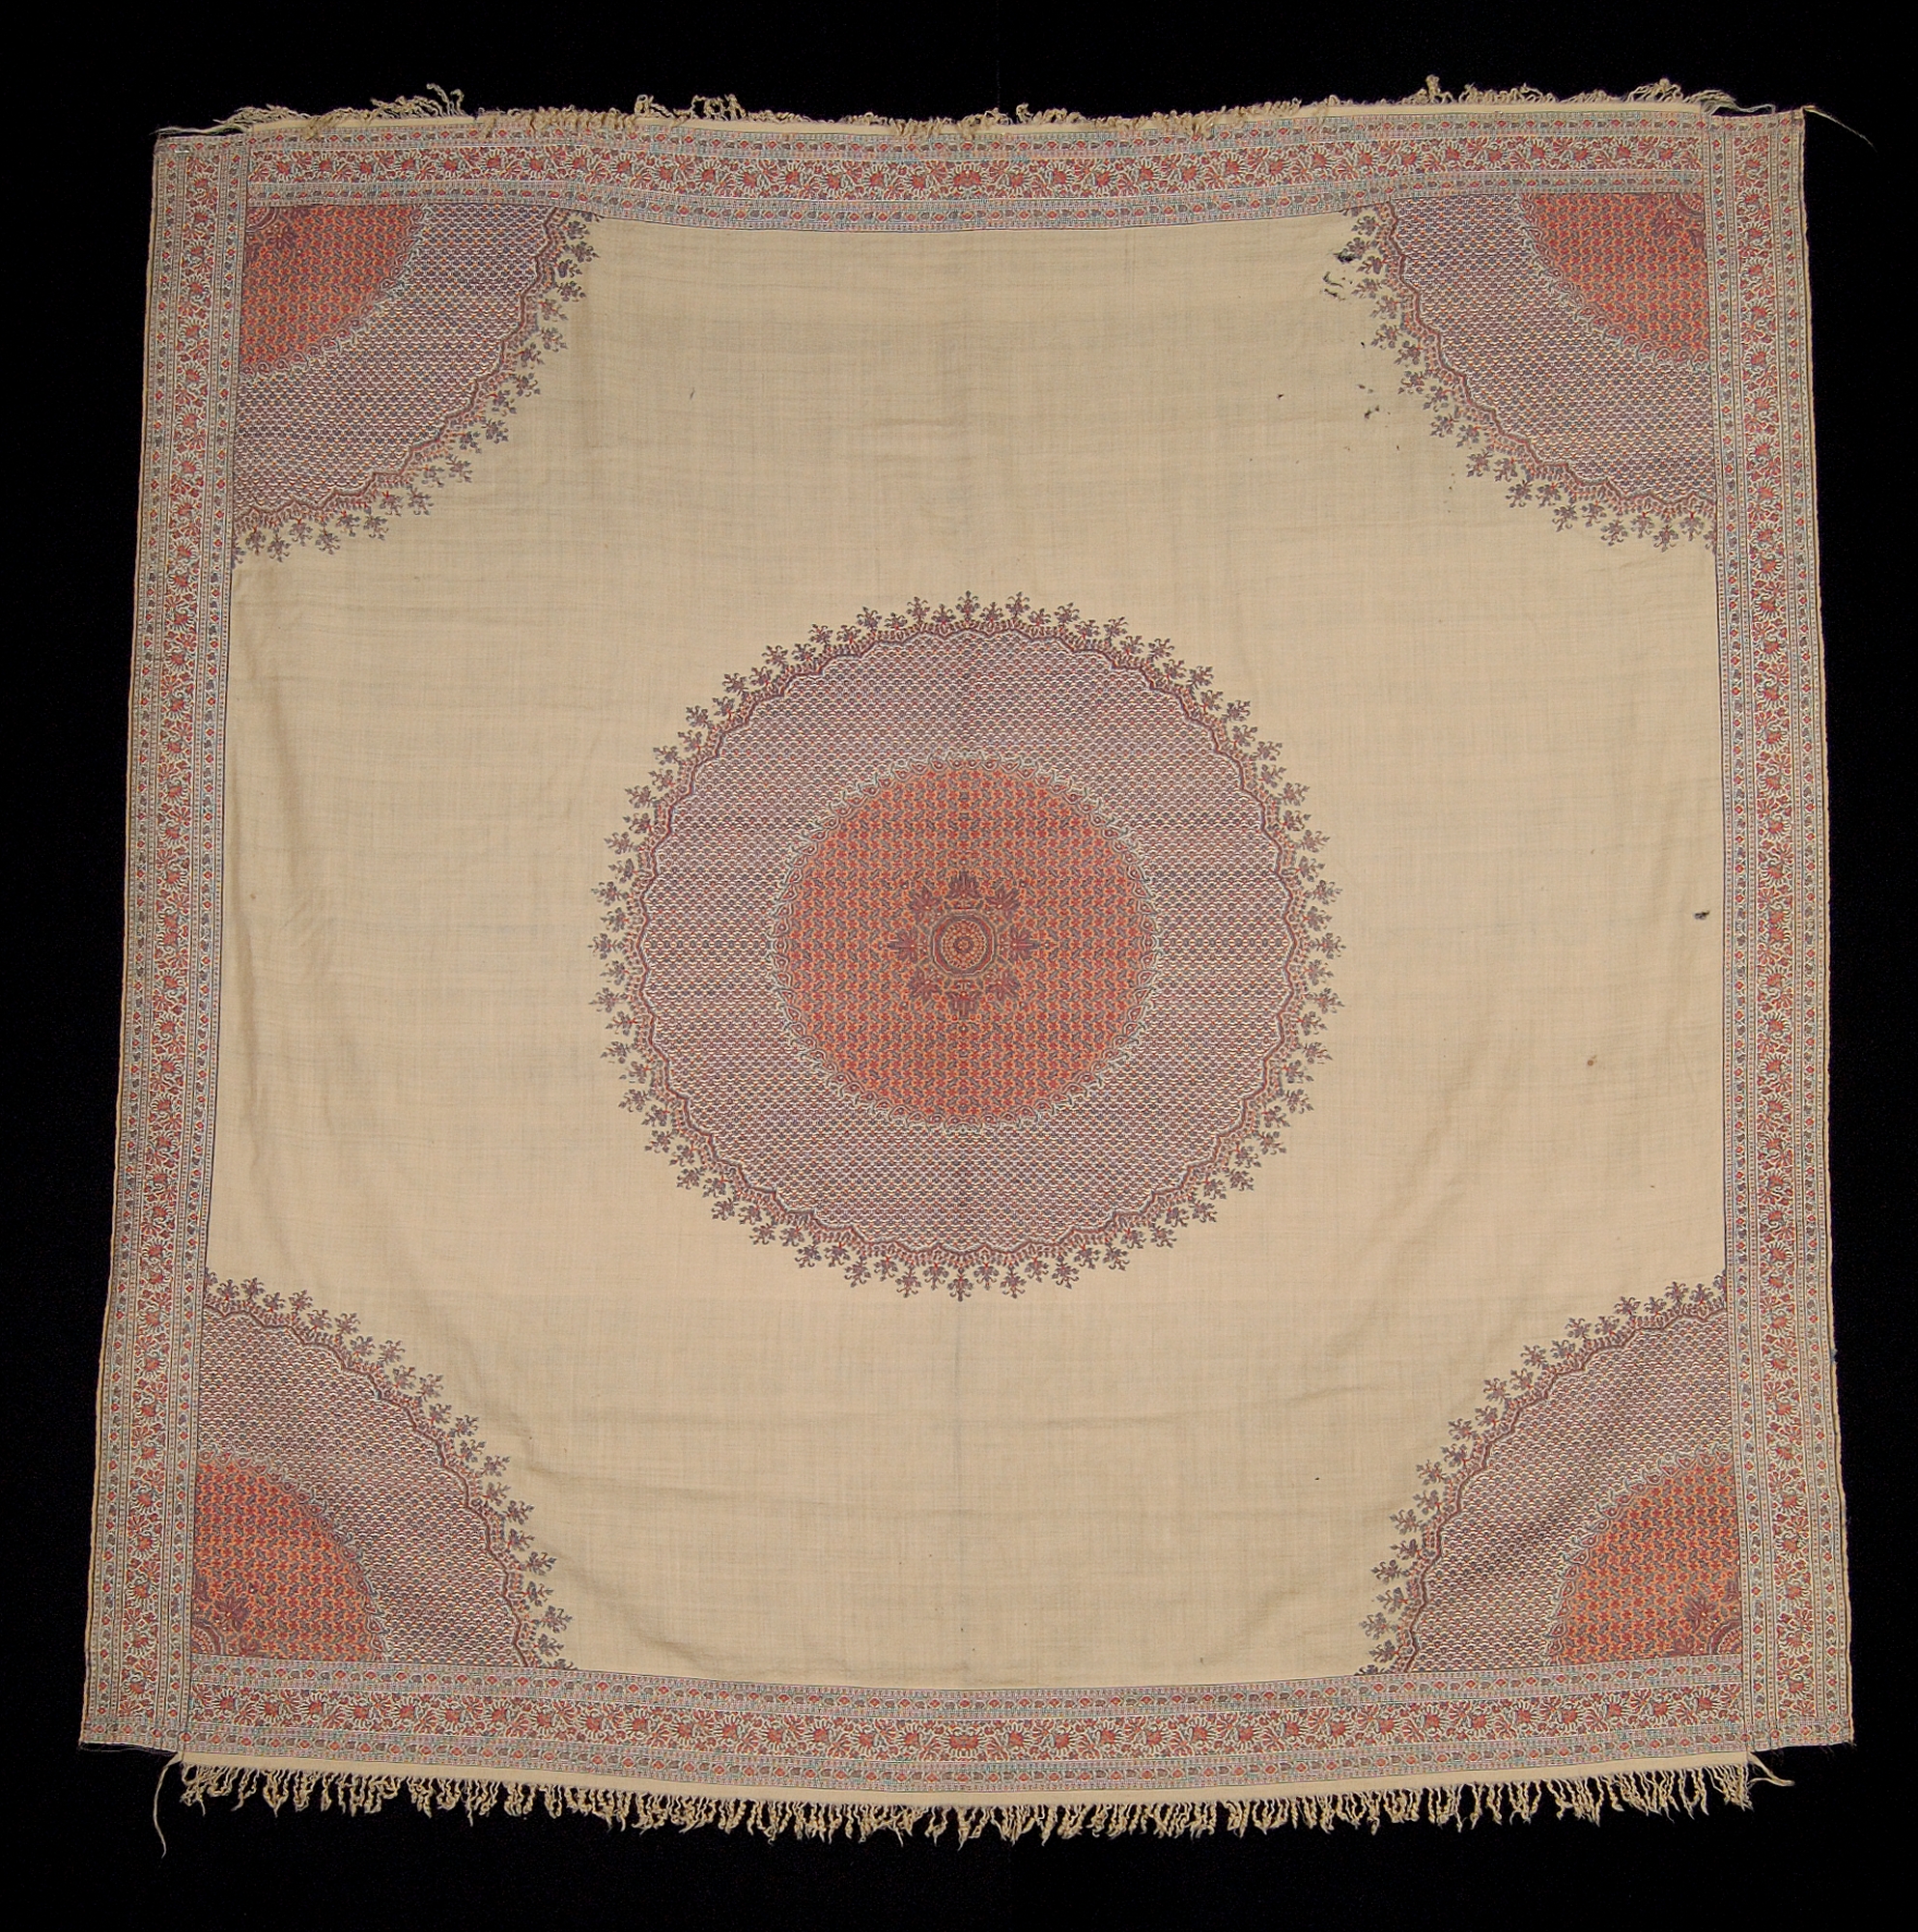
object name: shawl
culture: british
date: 1840-1849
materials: wool